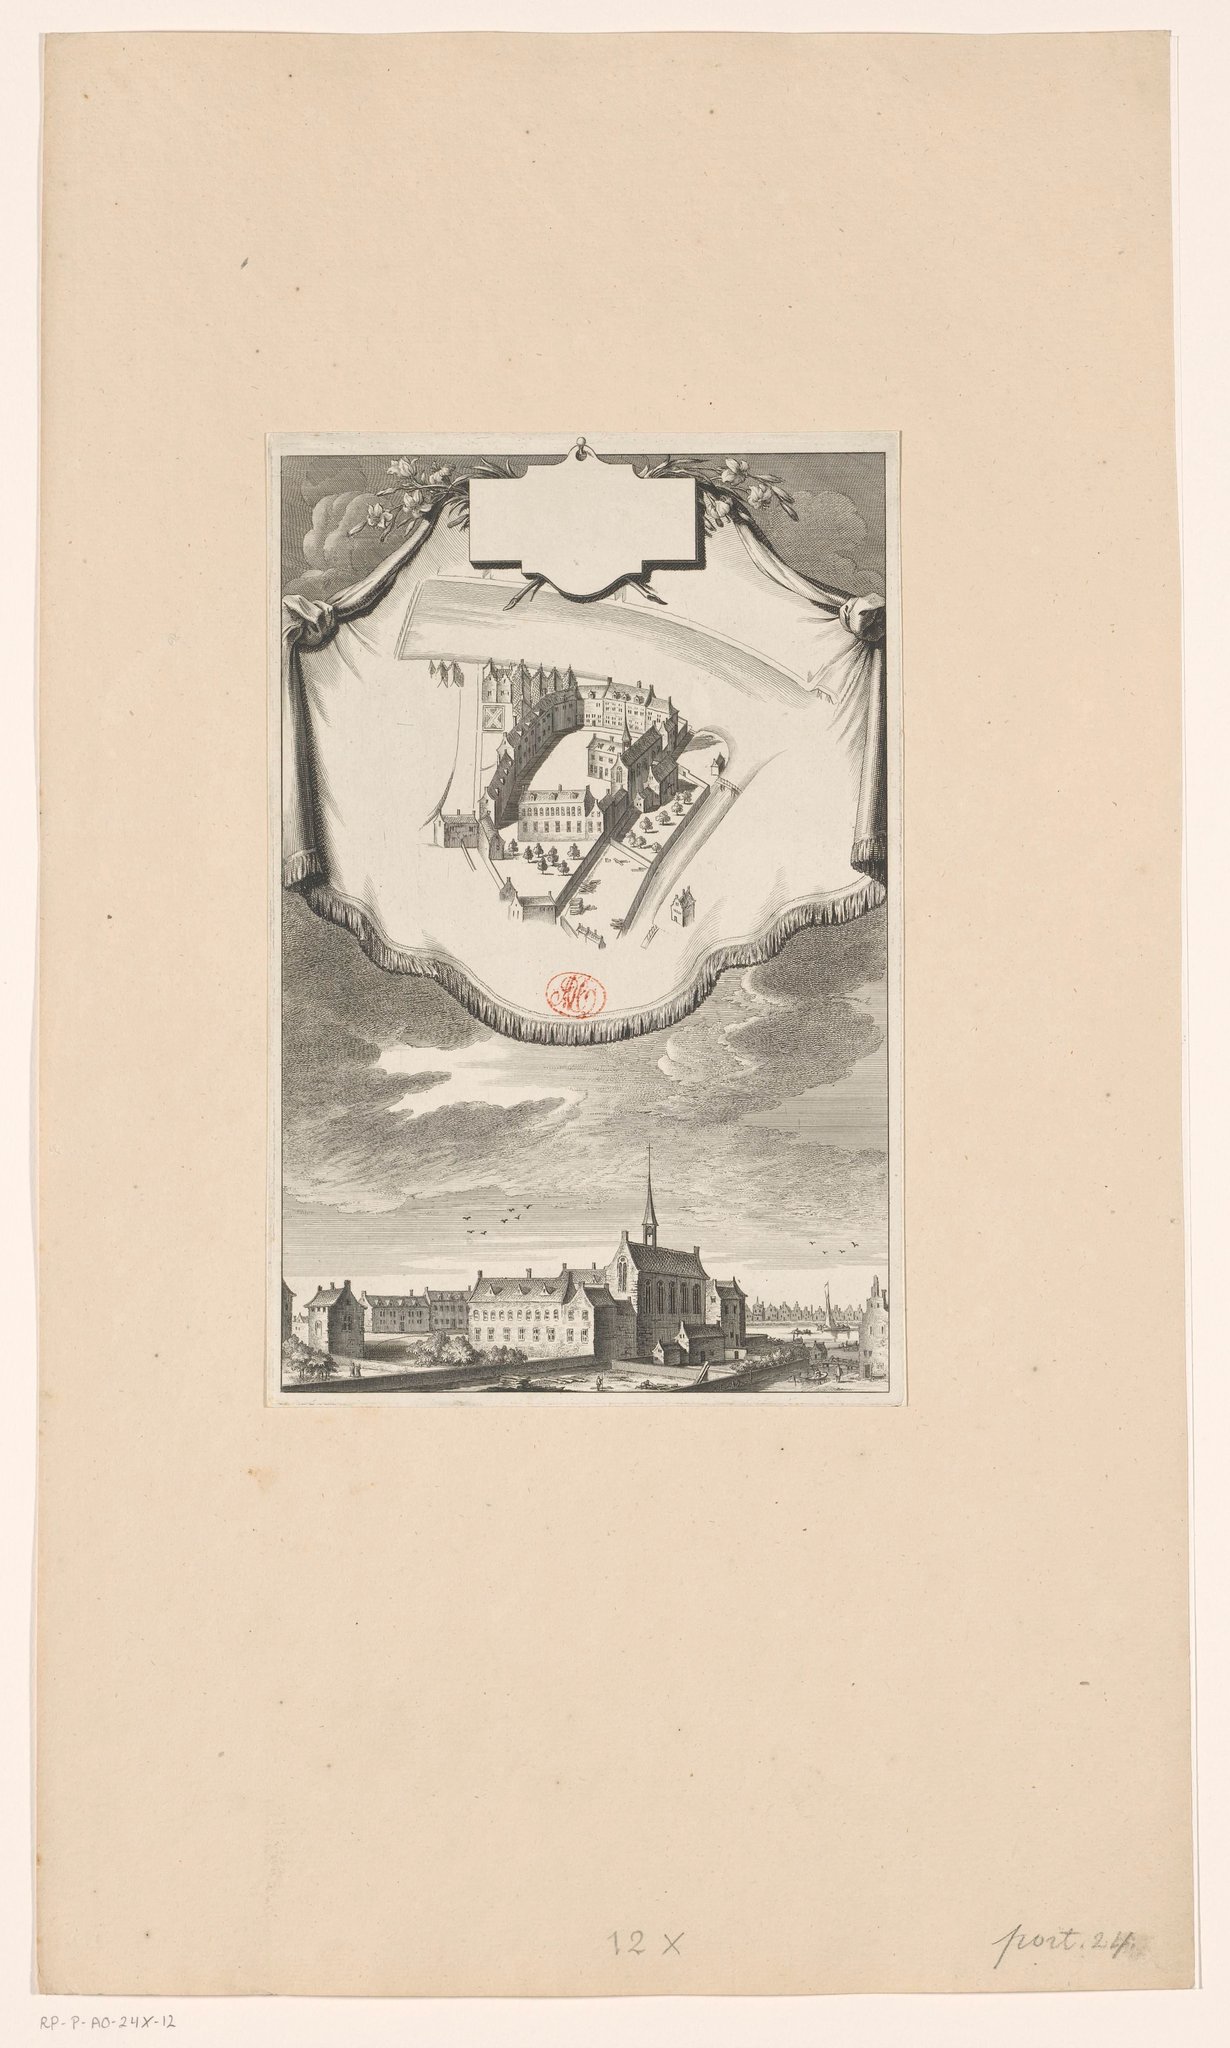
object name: print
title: Gezichten op het Nieuwe Nonnenklooster te Amsterdam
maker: Anonymous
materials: paper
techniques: engraving, etching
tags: abbey, monastery, convent ~ roman catholic church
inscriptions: collector's mark: Lugt 195, collector's mark: Lugt 2233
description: Latere staat van prent ook gebruikt in: Wagenaar, Jan. Amsterdam, in zyne opkomst, aanwas, geschiedenissen (…). 3 delen [folio-uitgave]. Amsterdam: Isaak Tirion en Yntema & Tieboel, 1760-1767, dl. 1 (Isaac Tirion, 1760). Zie RP-P-AO-24X-11 voor tweede staat. Dat de prent de situatie rond 1544 weergeeft gaat terug op het feit dat voor het maken van deze en andere prenten van kloosters en kerken van voor de Alteratie (1578) is uitgegaan van de plattegrond van Cornelis Anthonisz. uit 1544 (zie RP-P-OB-70.399 en RP-P-AO-20-15).